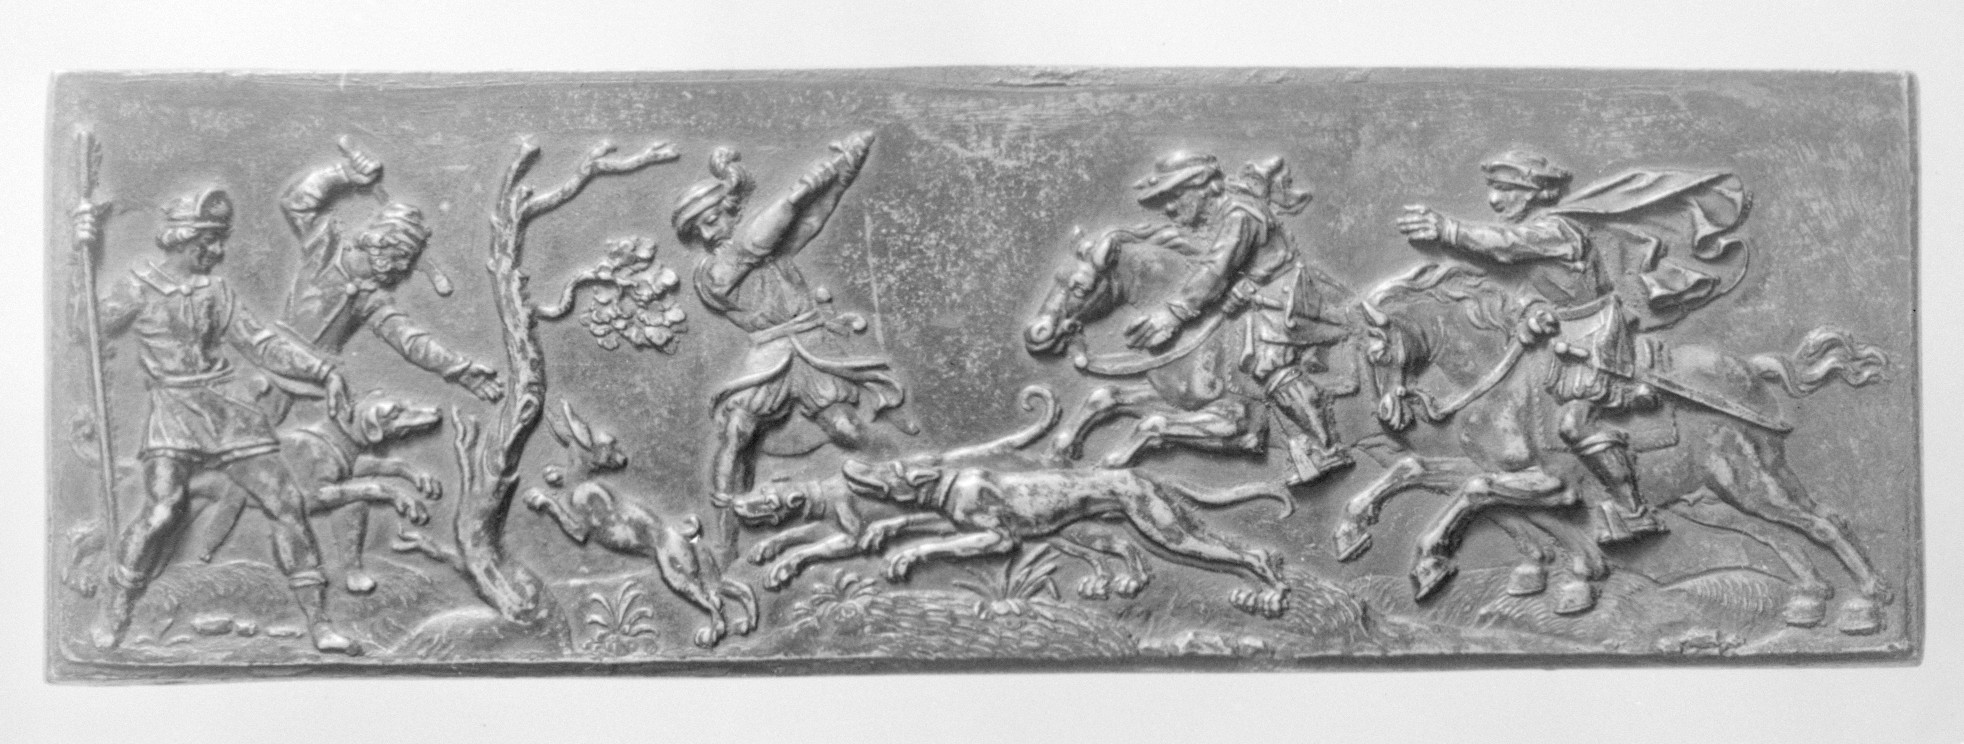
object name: plaquette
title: Hunting scene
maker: pankraz labenwolf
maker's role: artist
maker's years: 1492-1563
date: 1570-1580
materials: bronze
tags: animals,men,hunting